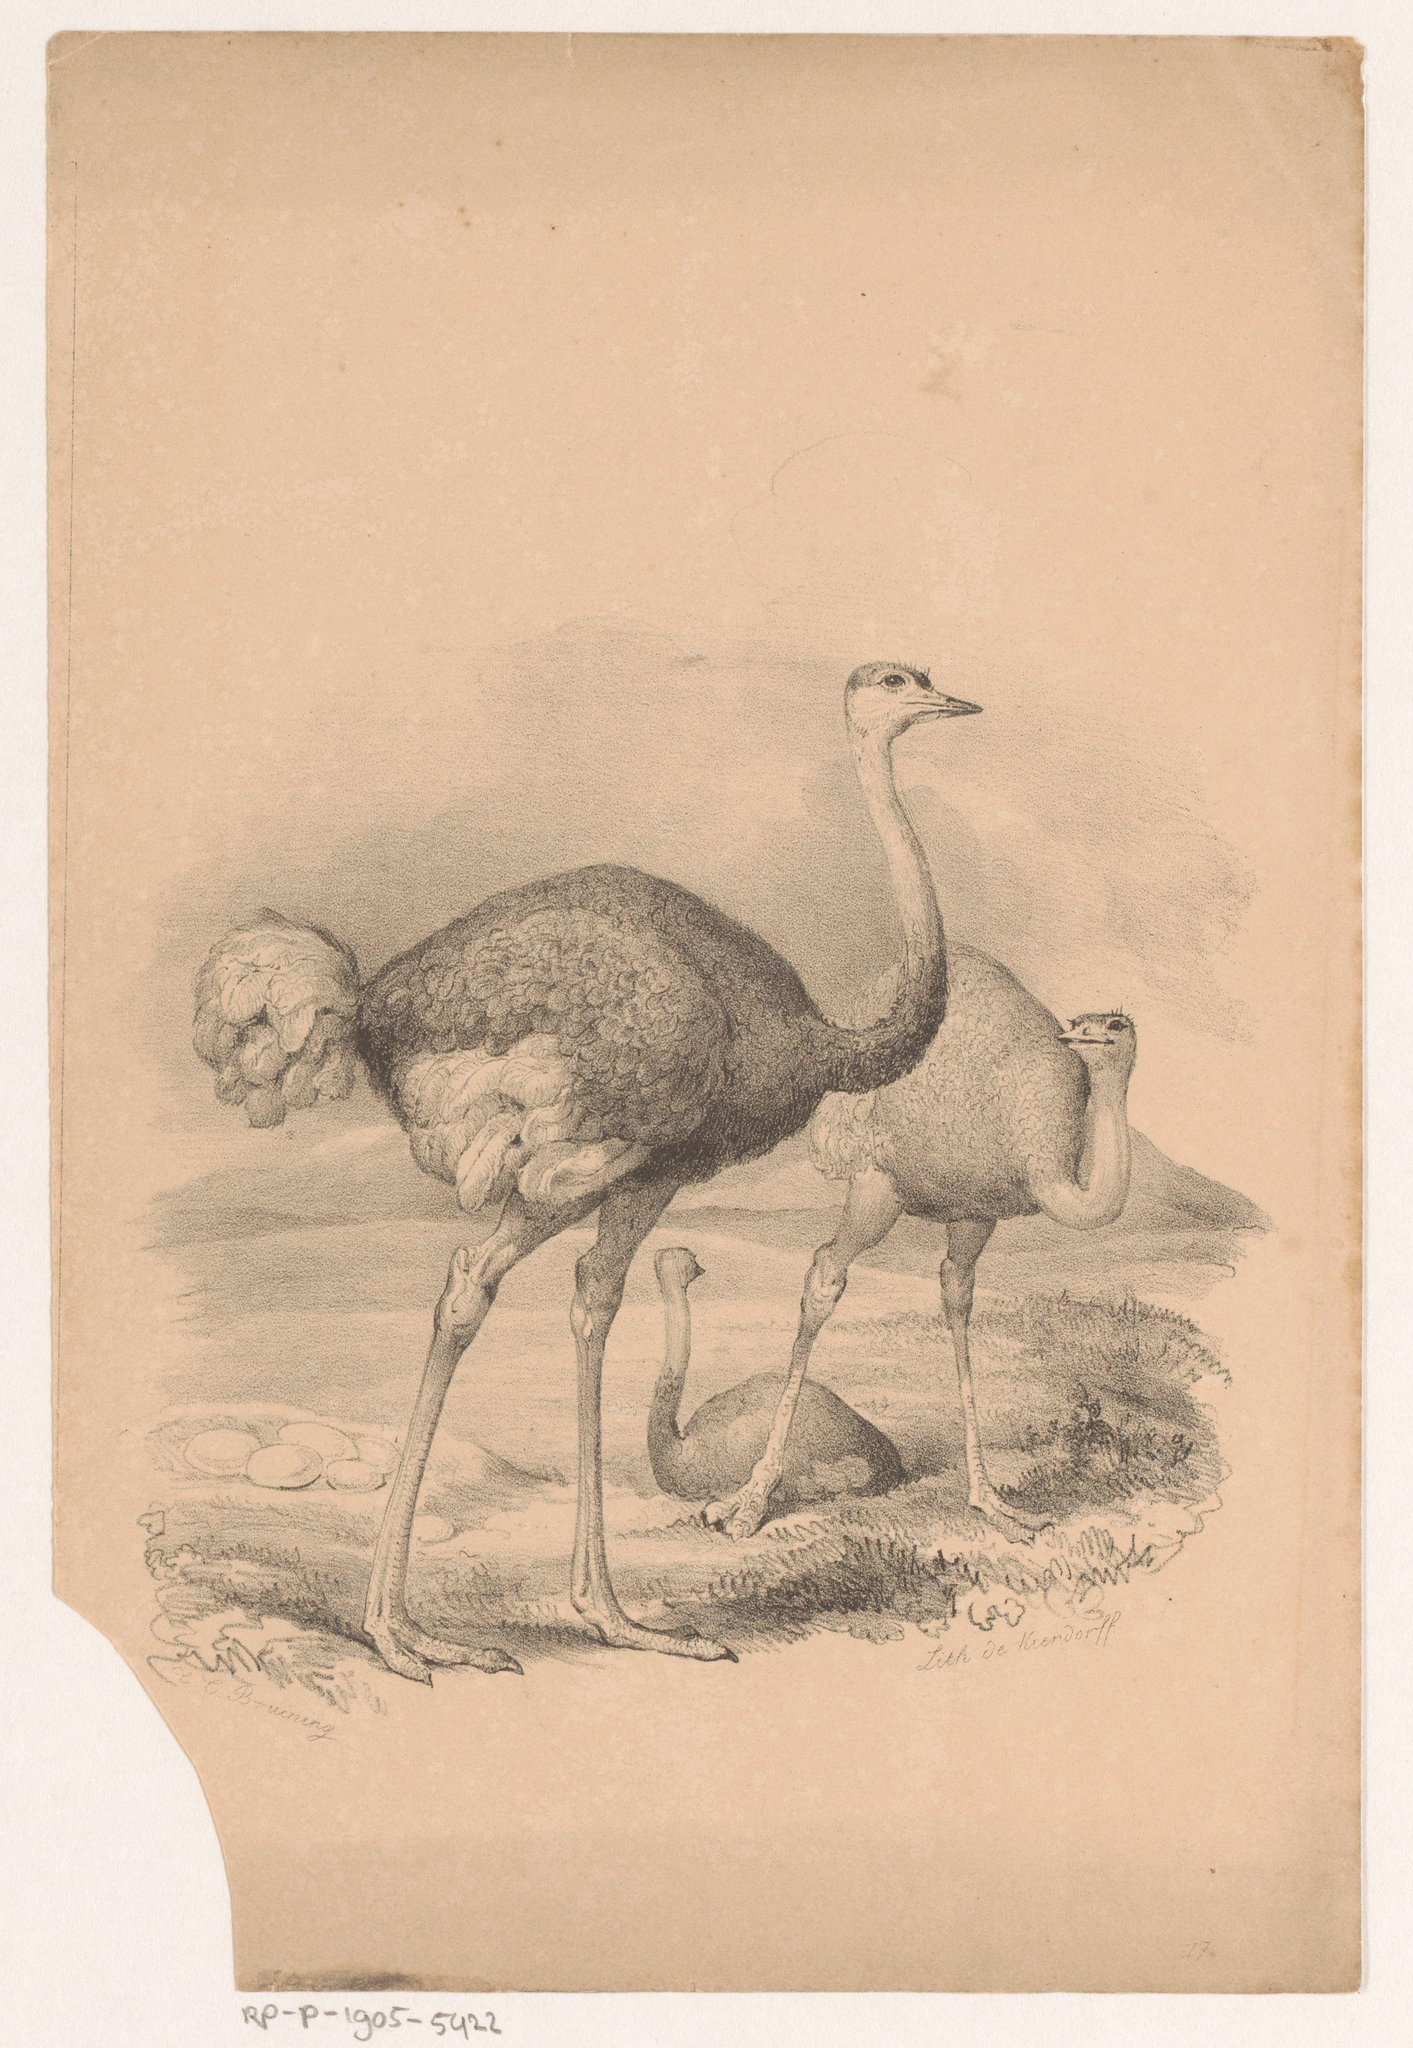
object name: print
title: Drie Afrikaanse struisvogels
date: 1842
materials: paper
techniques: lithograph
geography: netherlands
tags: walker and runner birds: ostrich, eggs, egg-dishes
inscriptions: collector's mark: Lugt 2228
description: Deze prent verscheen in: Schlegel, H. De Diergaarde en het Museum van het genootschap Natura Artis Magistra te Amsterdam. Amsterdam, M. Westerman & Zoon, 1842, t. o. p. 129.